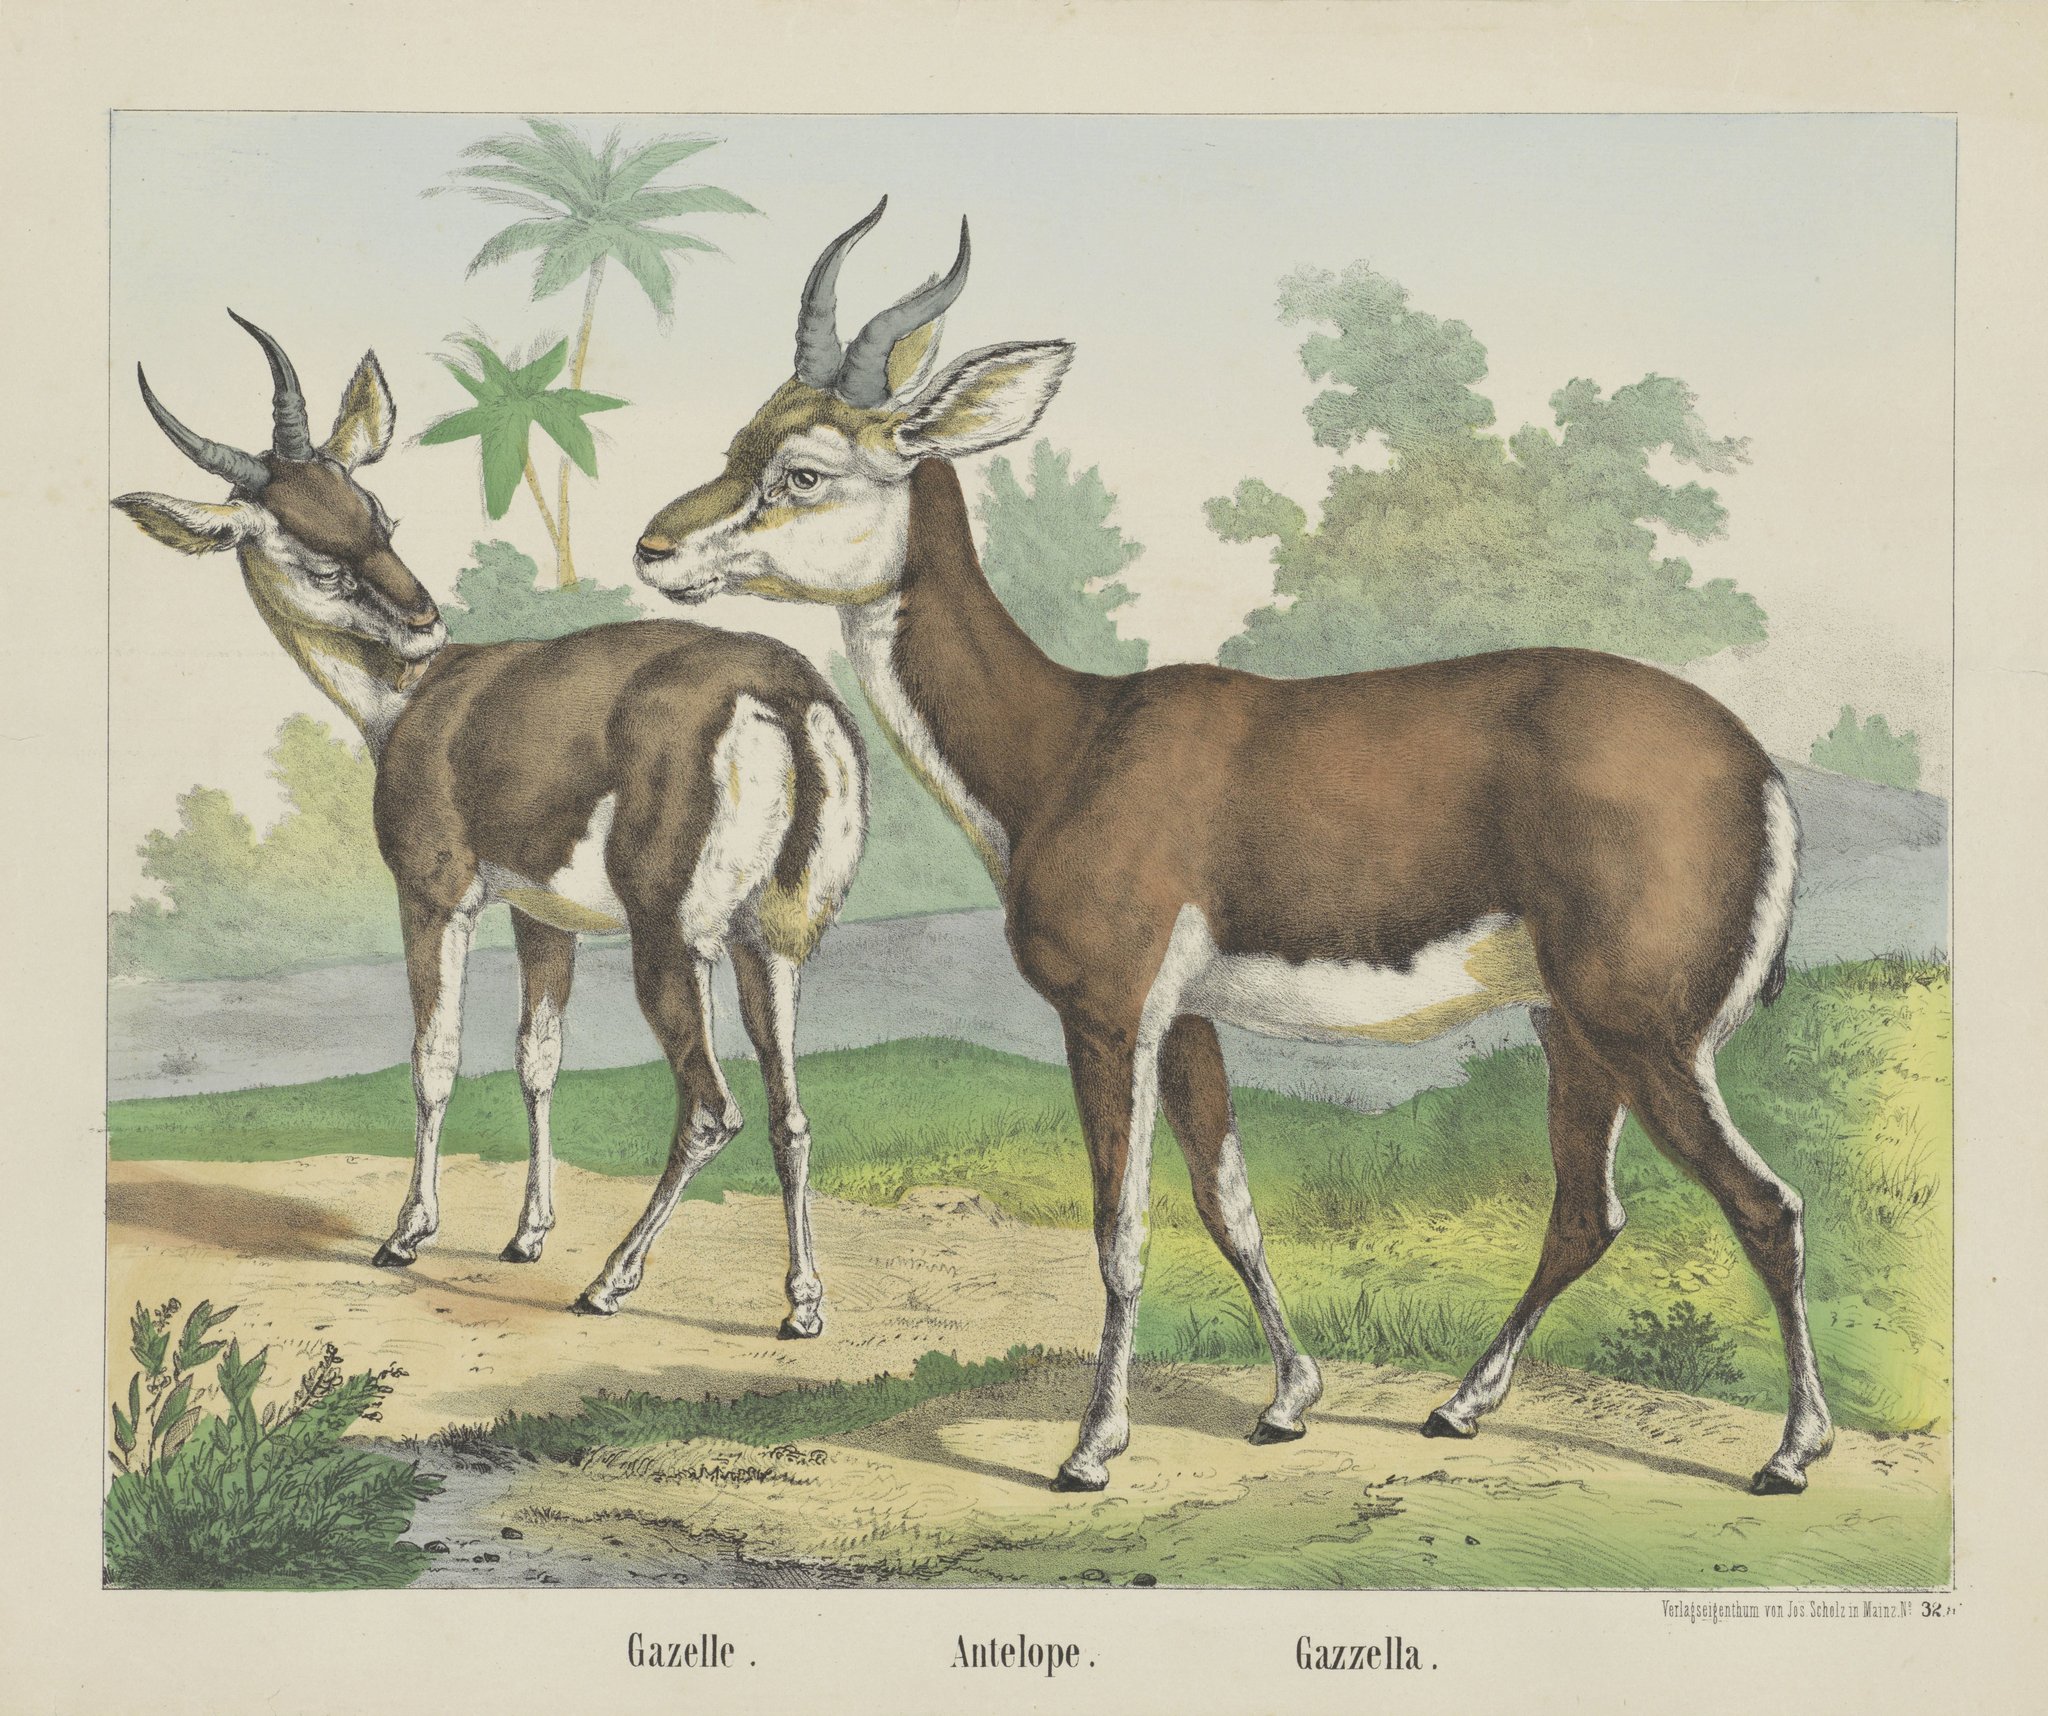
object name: popular print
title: Gazelle. / Antelope. / Gazella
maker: Anonymous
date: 1829-1880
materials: paper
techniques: colour, letterpress printing, lithograph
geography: mainz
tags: hoofed animals: gazelle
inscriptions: collector's mark: Lugt 2760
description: Twee gazellen in een graslandschap met bomen op de achtergrond. Genummerd rechtsonder: No. 32n.